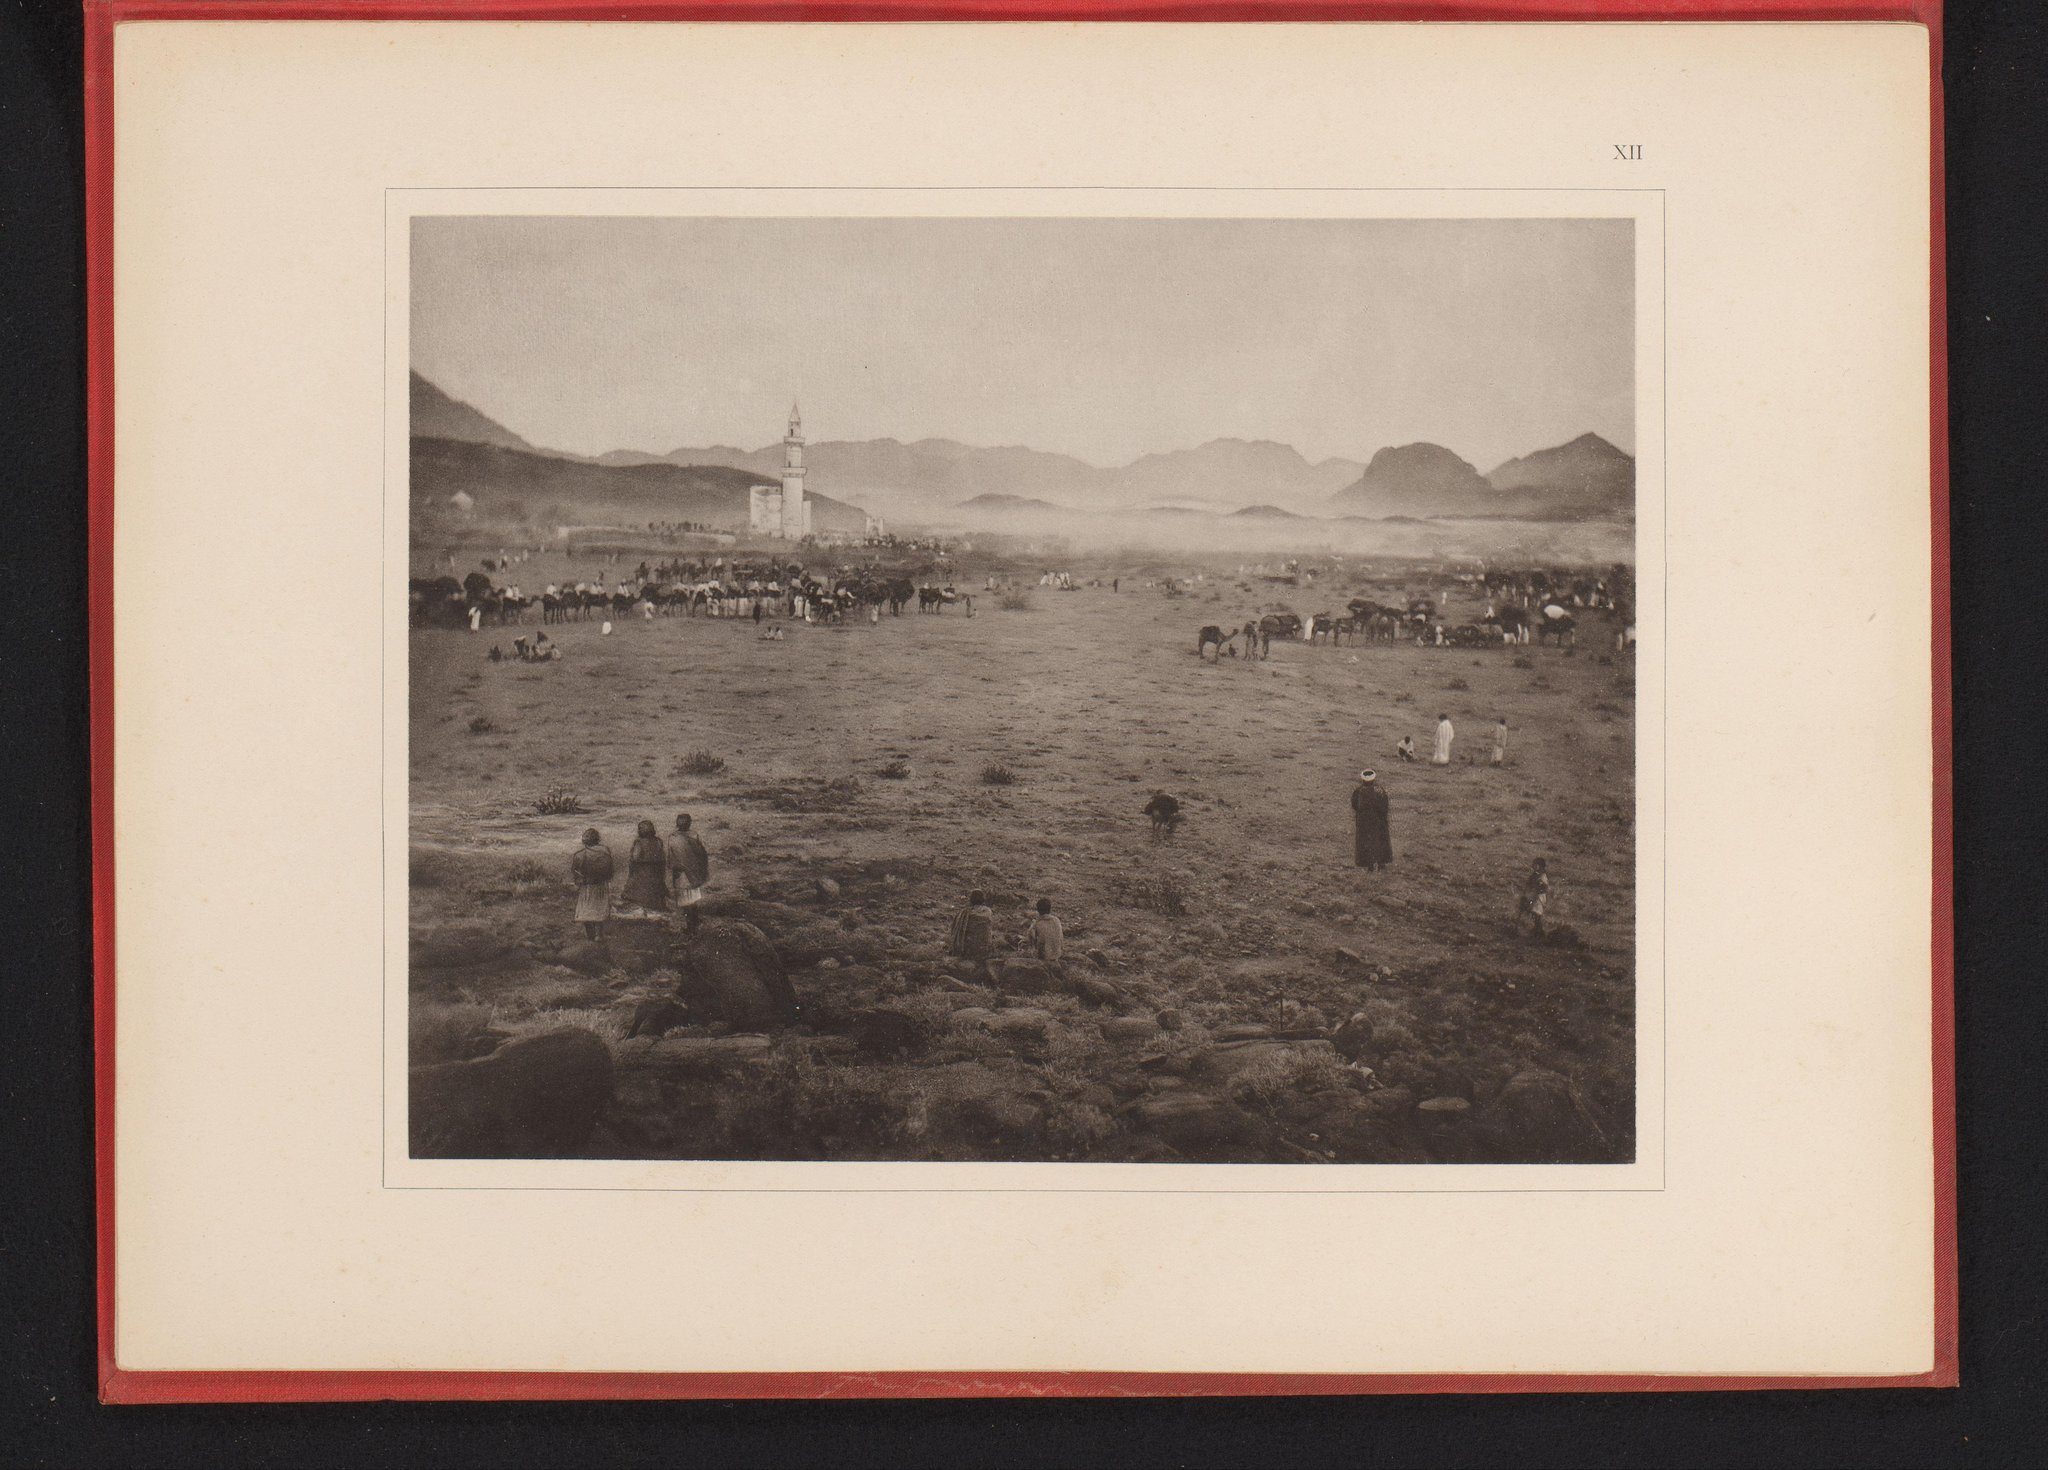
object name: album leaf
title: Gezicht op Muzdalifah, gelegen tussen Mina en de vlakte van Arafat, tijdens de Hadj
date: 1889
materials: cardboard, paper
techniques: photograph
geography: muzdalifah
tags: other ritual practices ~ islam, mohammedanism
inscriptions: number: ‘XII’